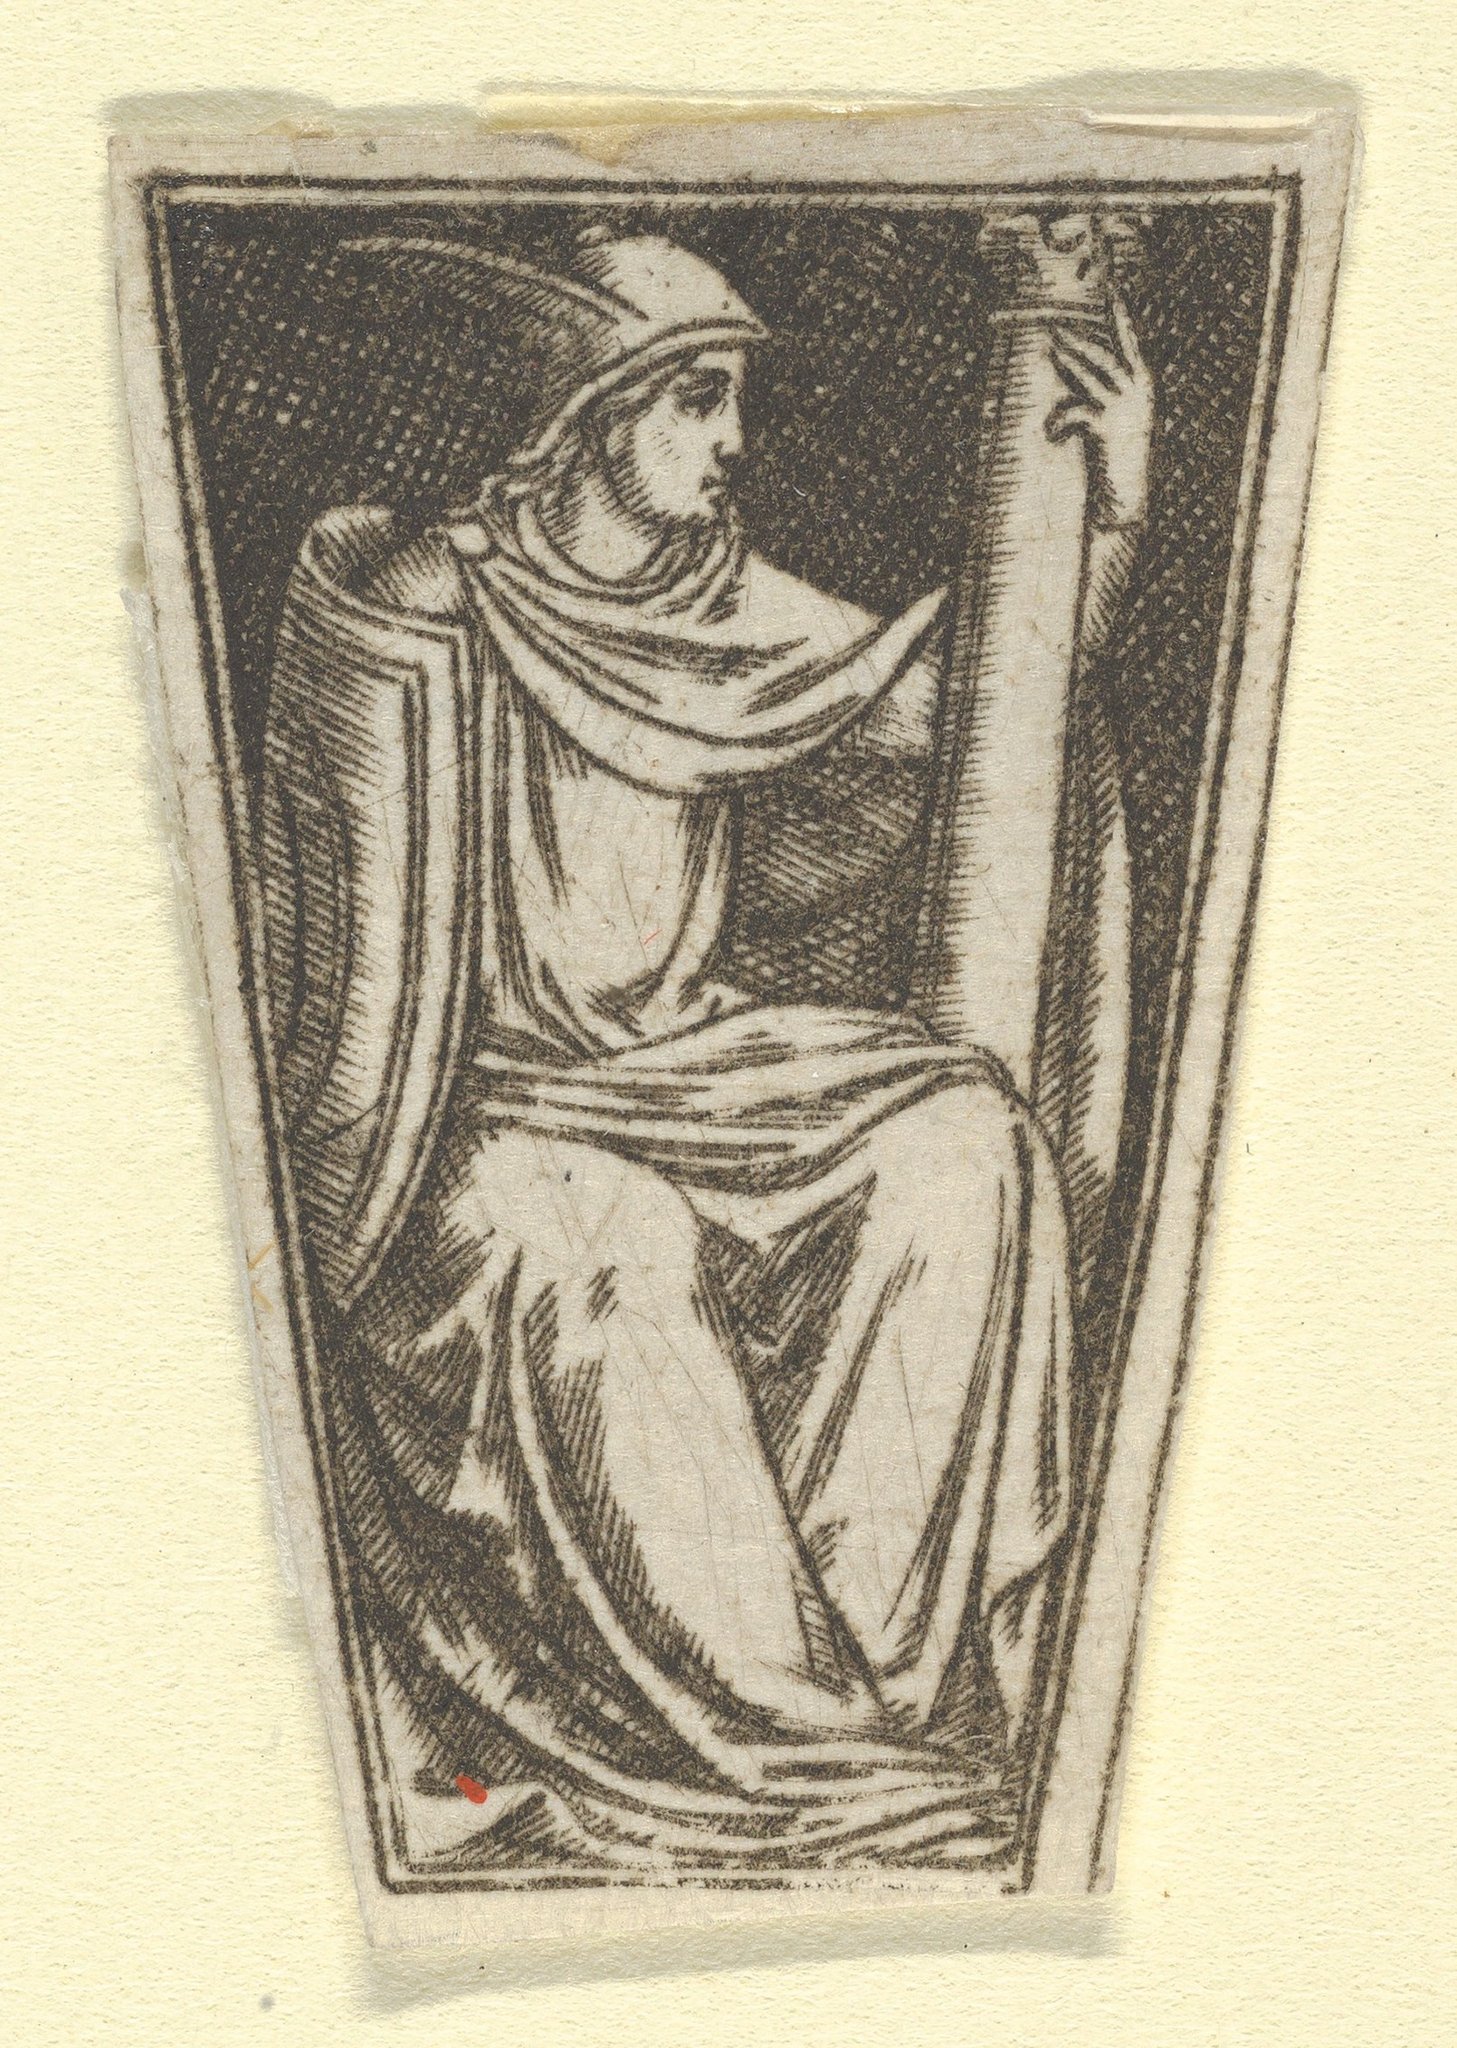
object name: print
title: The cardinal virtue of Fortitude represented by a seated woman, her right hand on a column (possibly a modern impression)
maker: Anonymous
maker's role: artist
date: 1480-1520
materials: niello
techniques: engraving, printing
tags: women